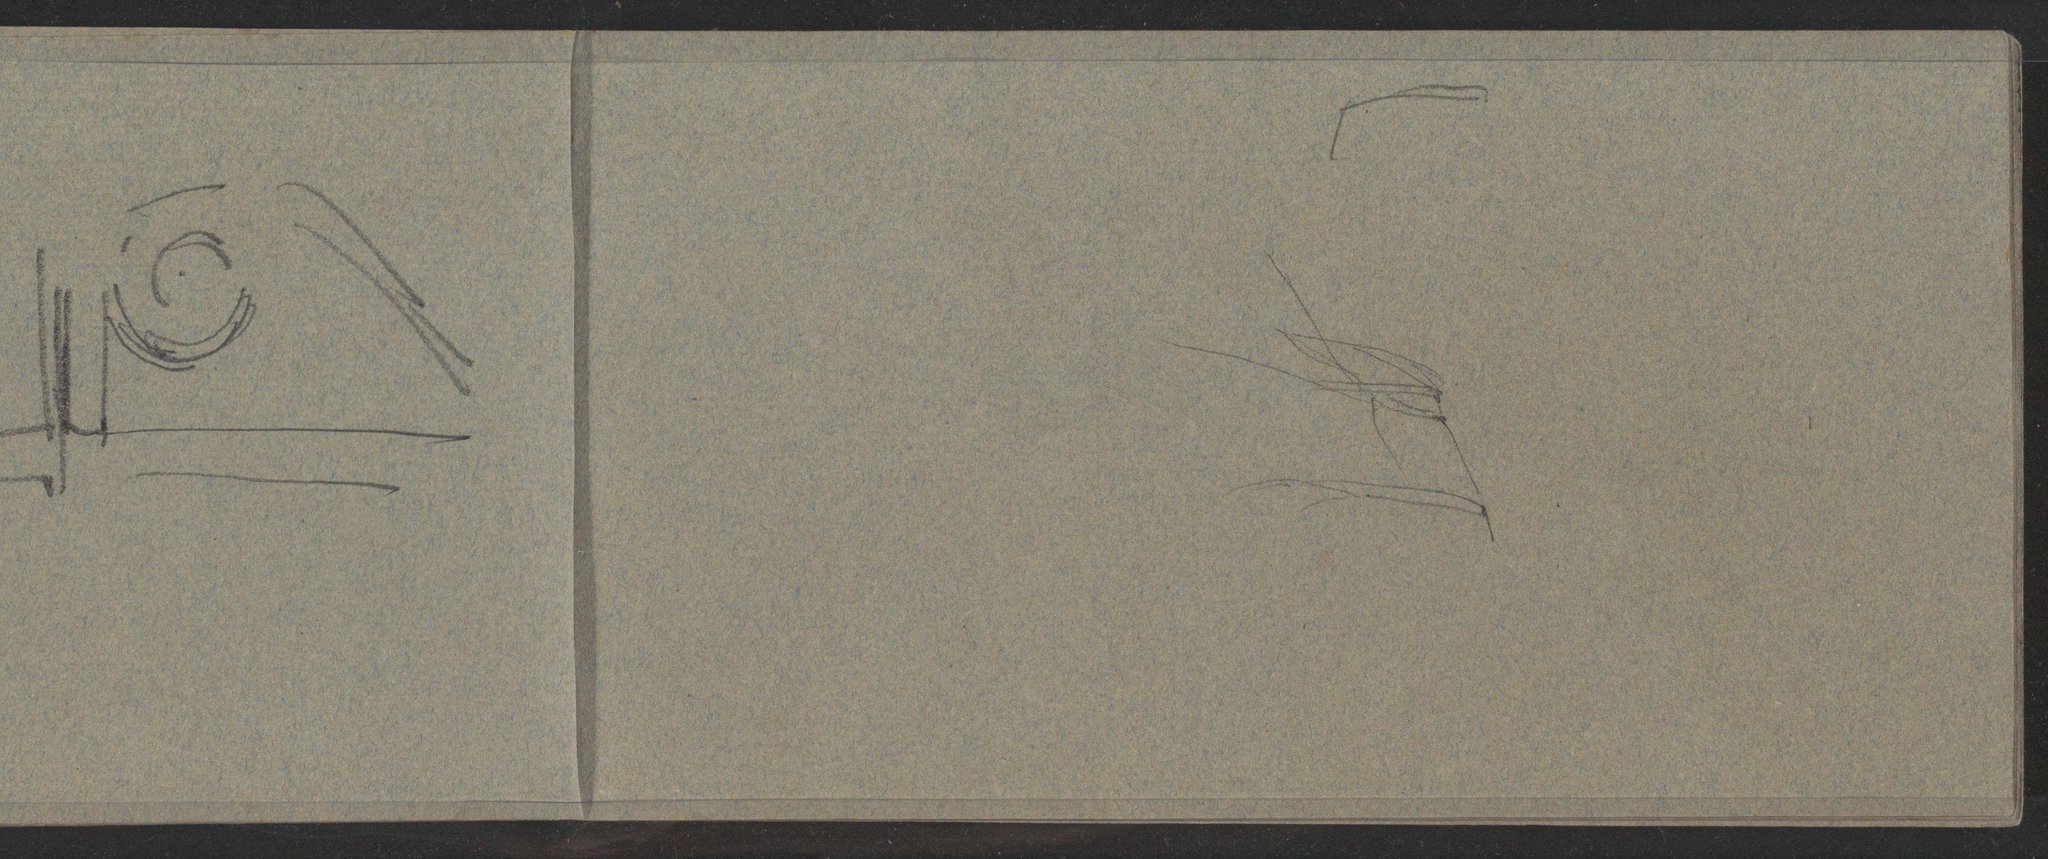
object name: sketchbook leaf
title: Studie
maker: george hendrik breitner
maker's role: draughtsman, painter, print maker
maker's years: 1857-1923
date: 1883-1885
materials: paper, pencil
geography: the hague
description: Blad 3A uit een schetsboek met 36 bladen.